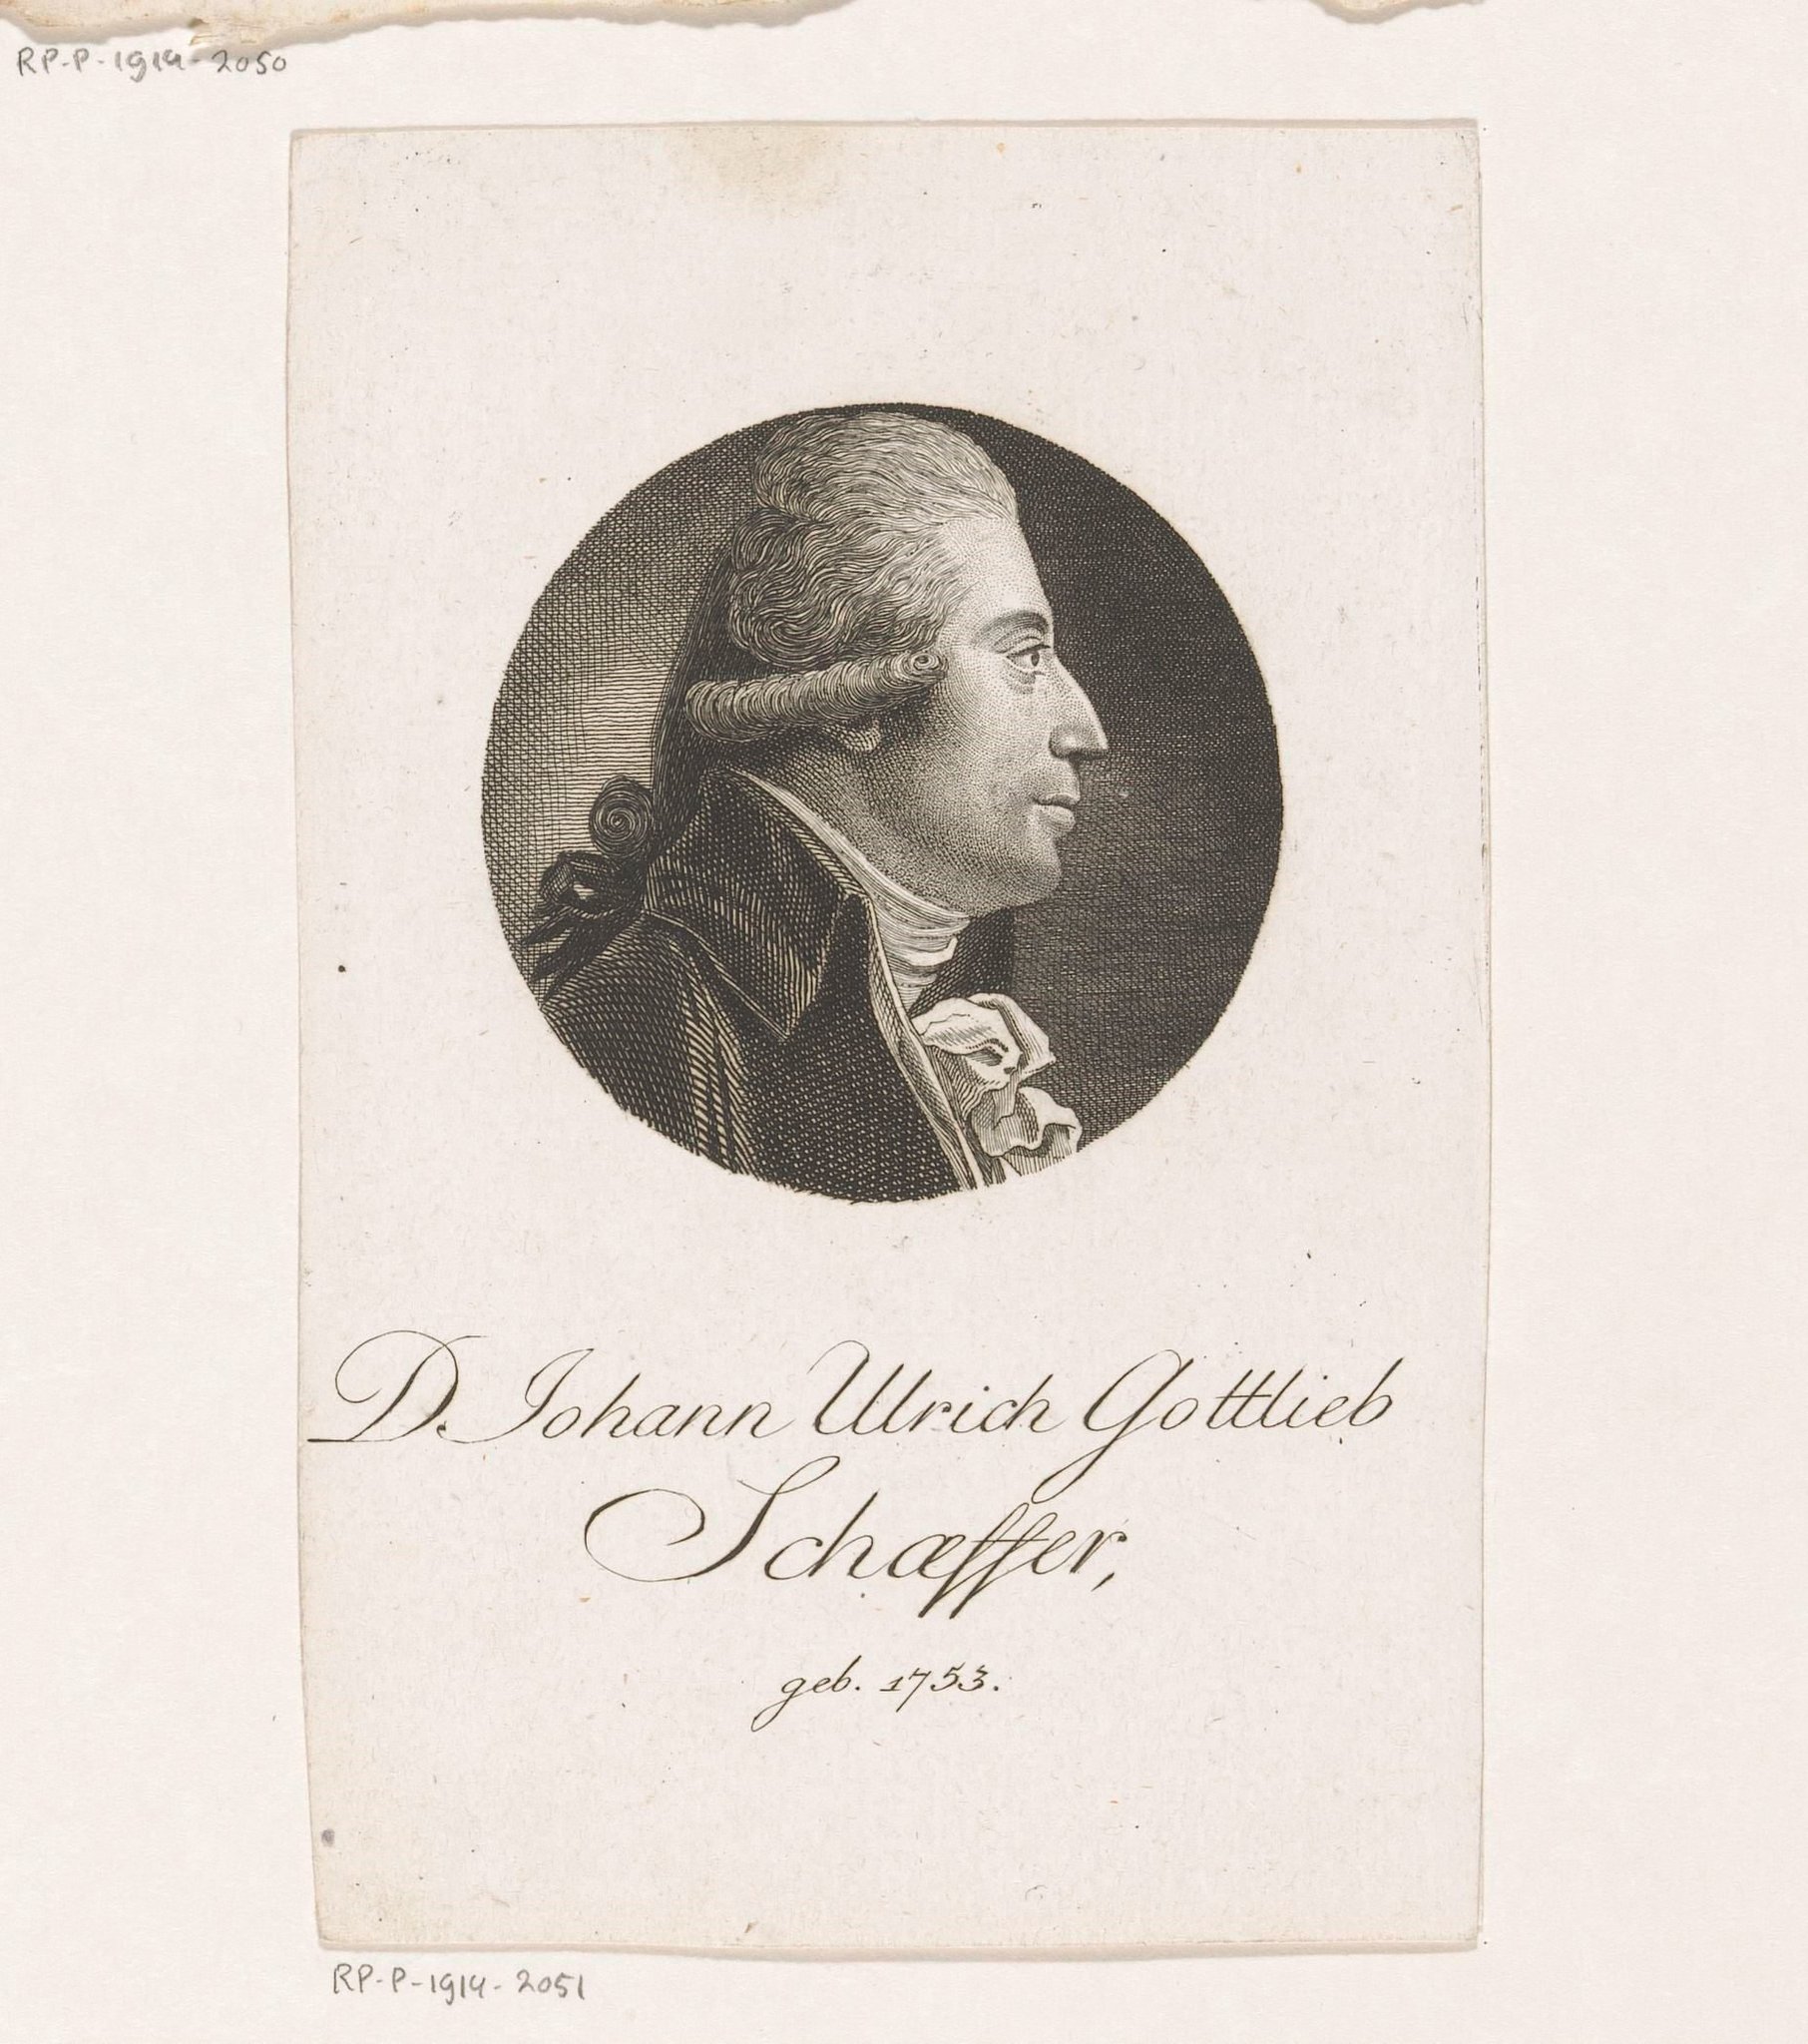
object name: print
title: Portret van Johann Ulrich Gottlieb Schaeffer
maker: christoph wilhelm bock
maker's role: print maker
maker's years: 1755-1836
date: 1775-1829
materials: paper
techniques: engraving, etching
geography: nuremberg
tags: historical persons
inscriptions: collector's mark: Lugt 2228